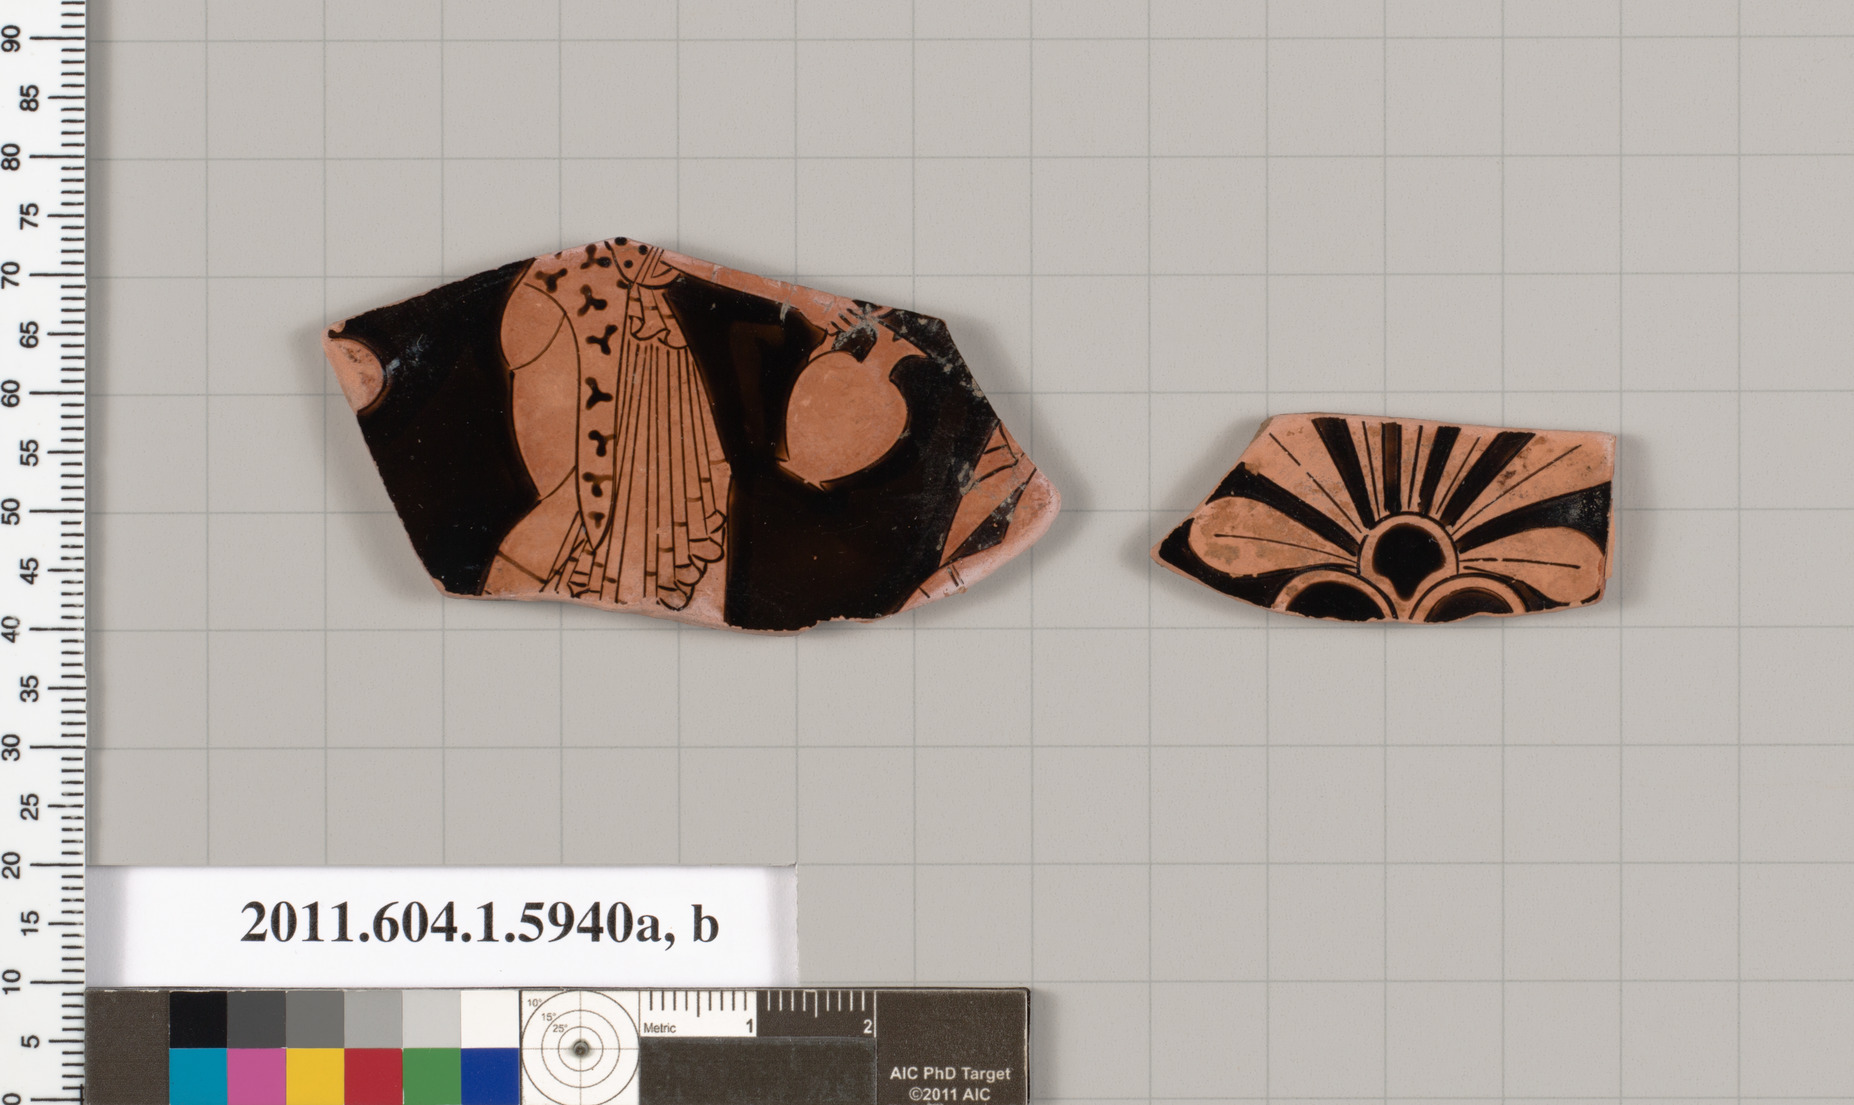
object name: kylix fragment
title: Terracotta fragment of a kylix (drinking cup)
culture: greek, attic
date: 433-567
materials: terracotta